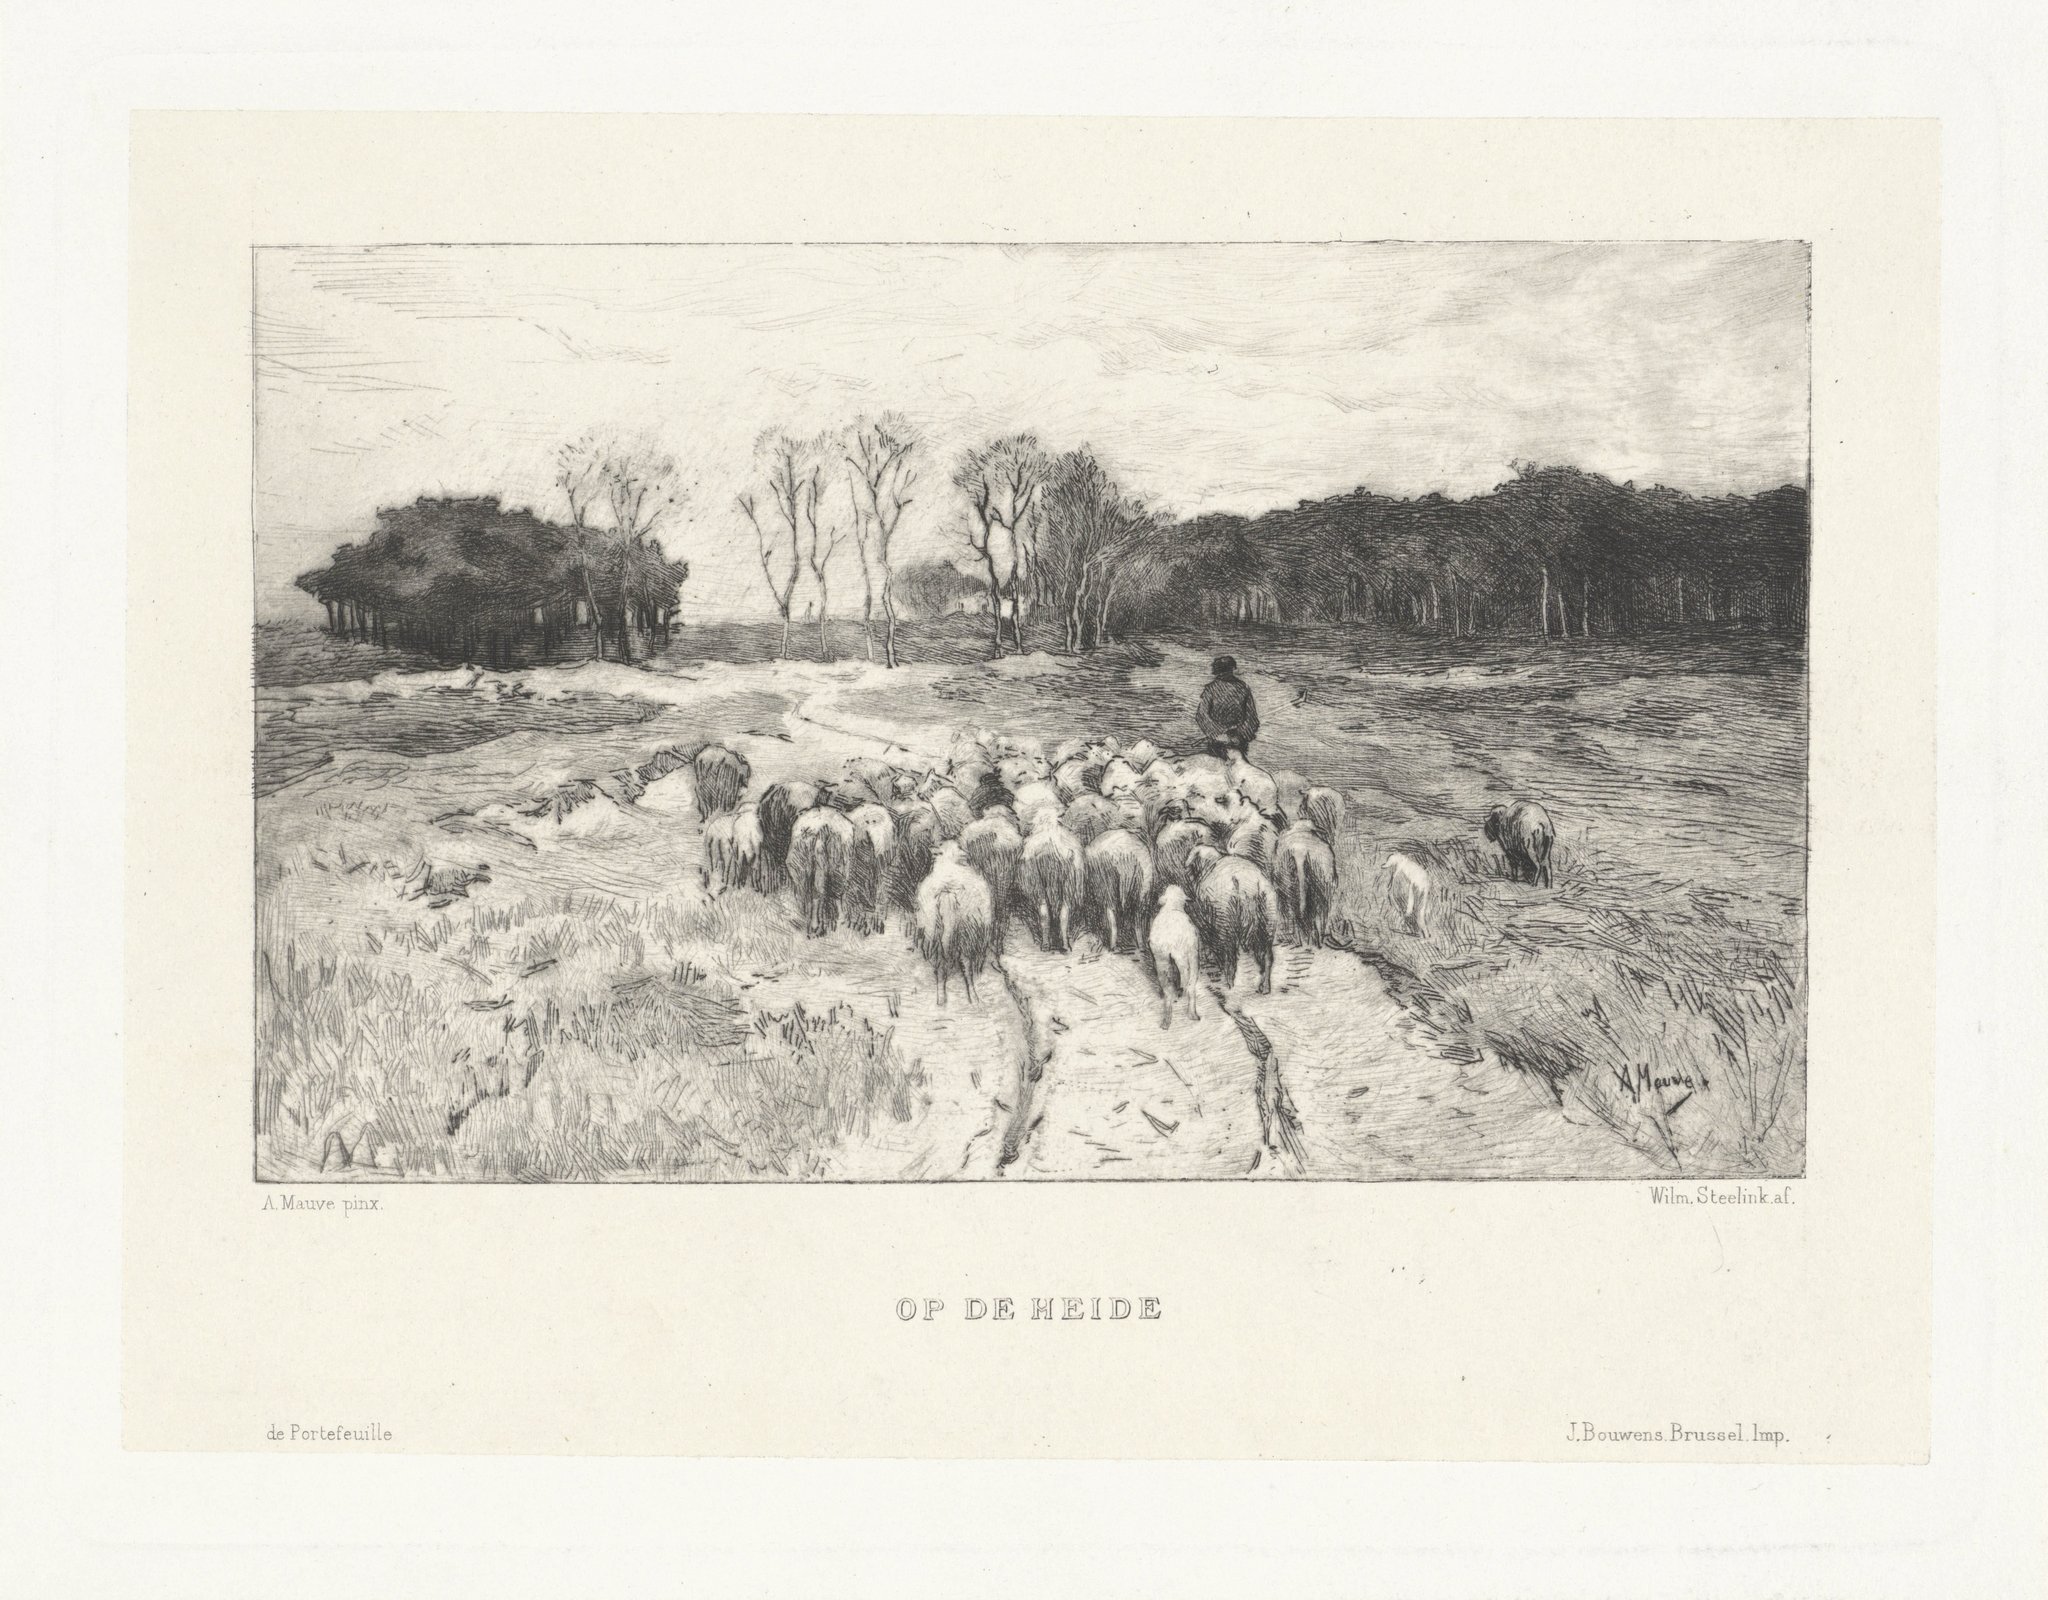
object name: print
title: Schaapherder met kudde op de hei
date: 1866-1897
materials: paper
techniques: etching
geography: brussels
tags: herd, flock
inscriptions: collector's mark: Lugt 2228